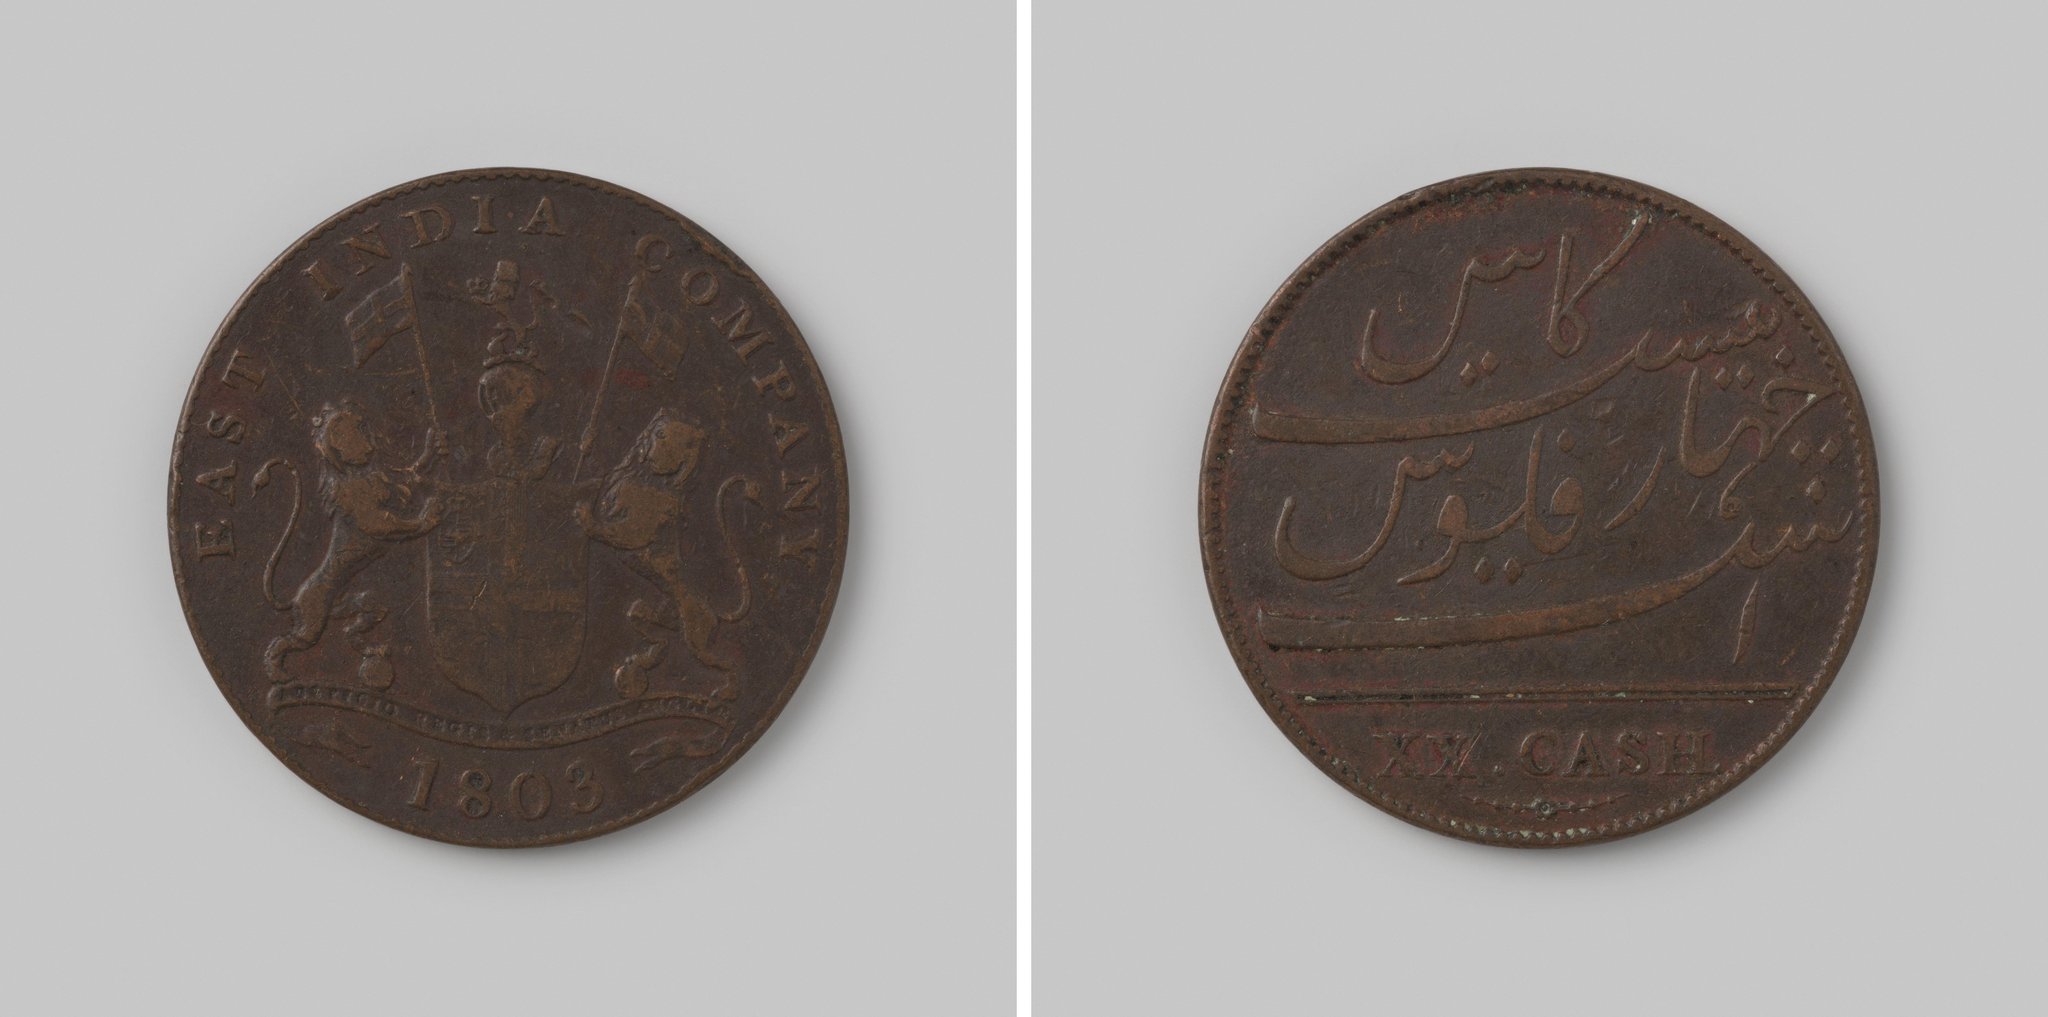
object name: coin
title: 20 cash voor Madras in India van de Engelse Oostindische Compagnie (EIC), 1803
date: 1803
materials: copper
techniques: striking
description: Koperen munt. Voorzijde: door twee op banderol, waarin opschrift, staande leeuwen met pijl, waaraan vlag in de klauw, gehouden wapenschild van de EIC, waarboven helmteken. Jaartal onderaan. Keerzijde: in Arabische lettertekens opschrift in drie regels. In afsnede waarde-aanduiding: XX Cash. Gladde rand.